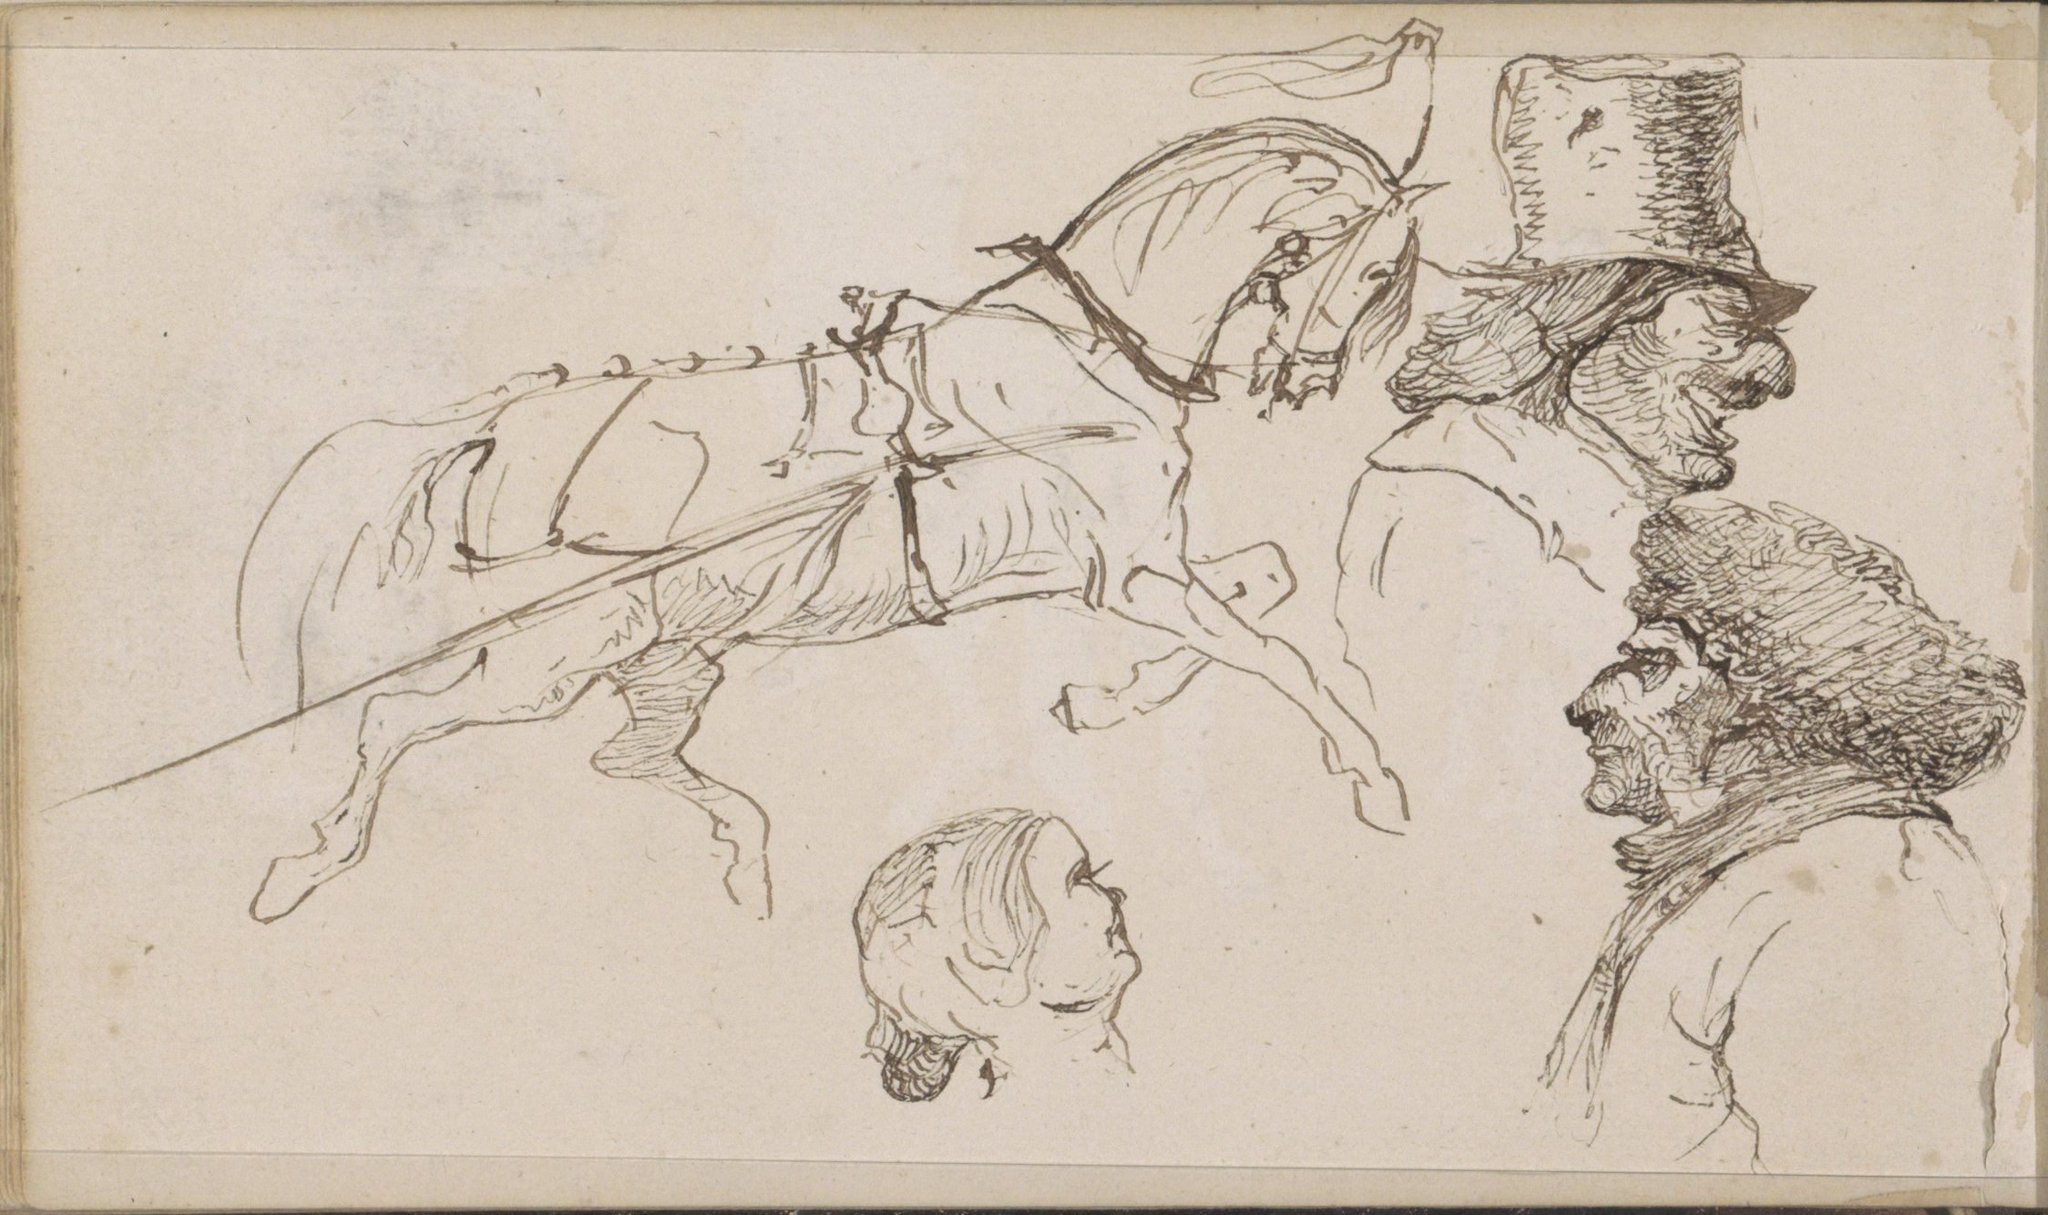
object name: sketchbook leaf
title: Paard in galop en twee mannen- en één vrouwenkop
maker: johannes tavenraat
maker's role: draughtsman, painter, print maker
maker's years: 1809-1881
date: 1864-1880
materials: ink, paper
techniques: pen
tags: head (human), adult woman, adult man, galloping horse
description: Blad 14 verso uit een schetsboek met 98 bladen.